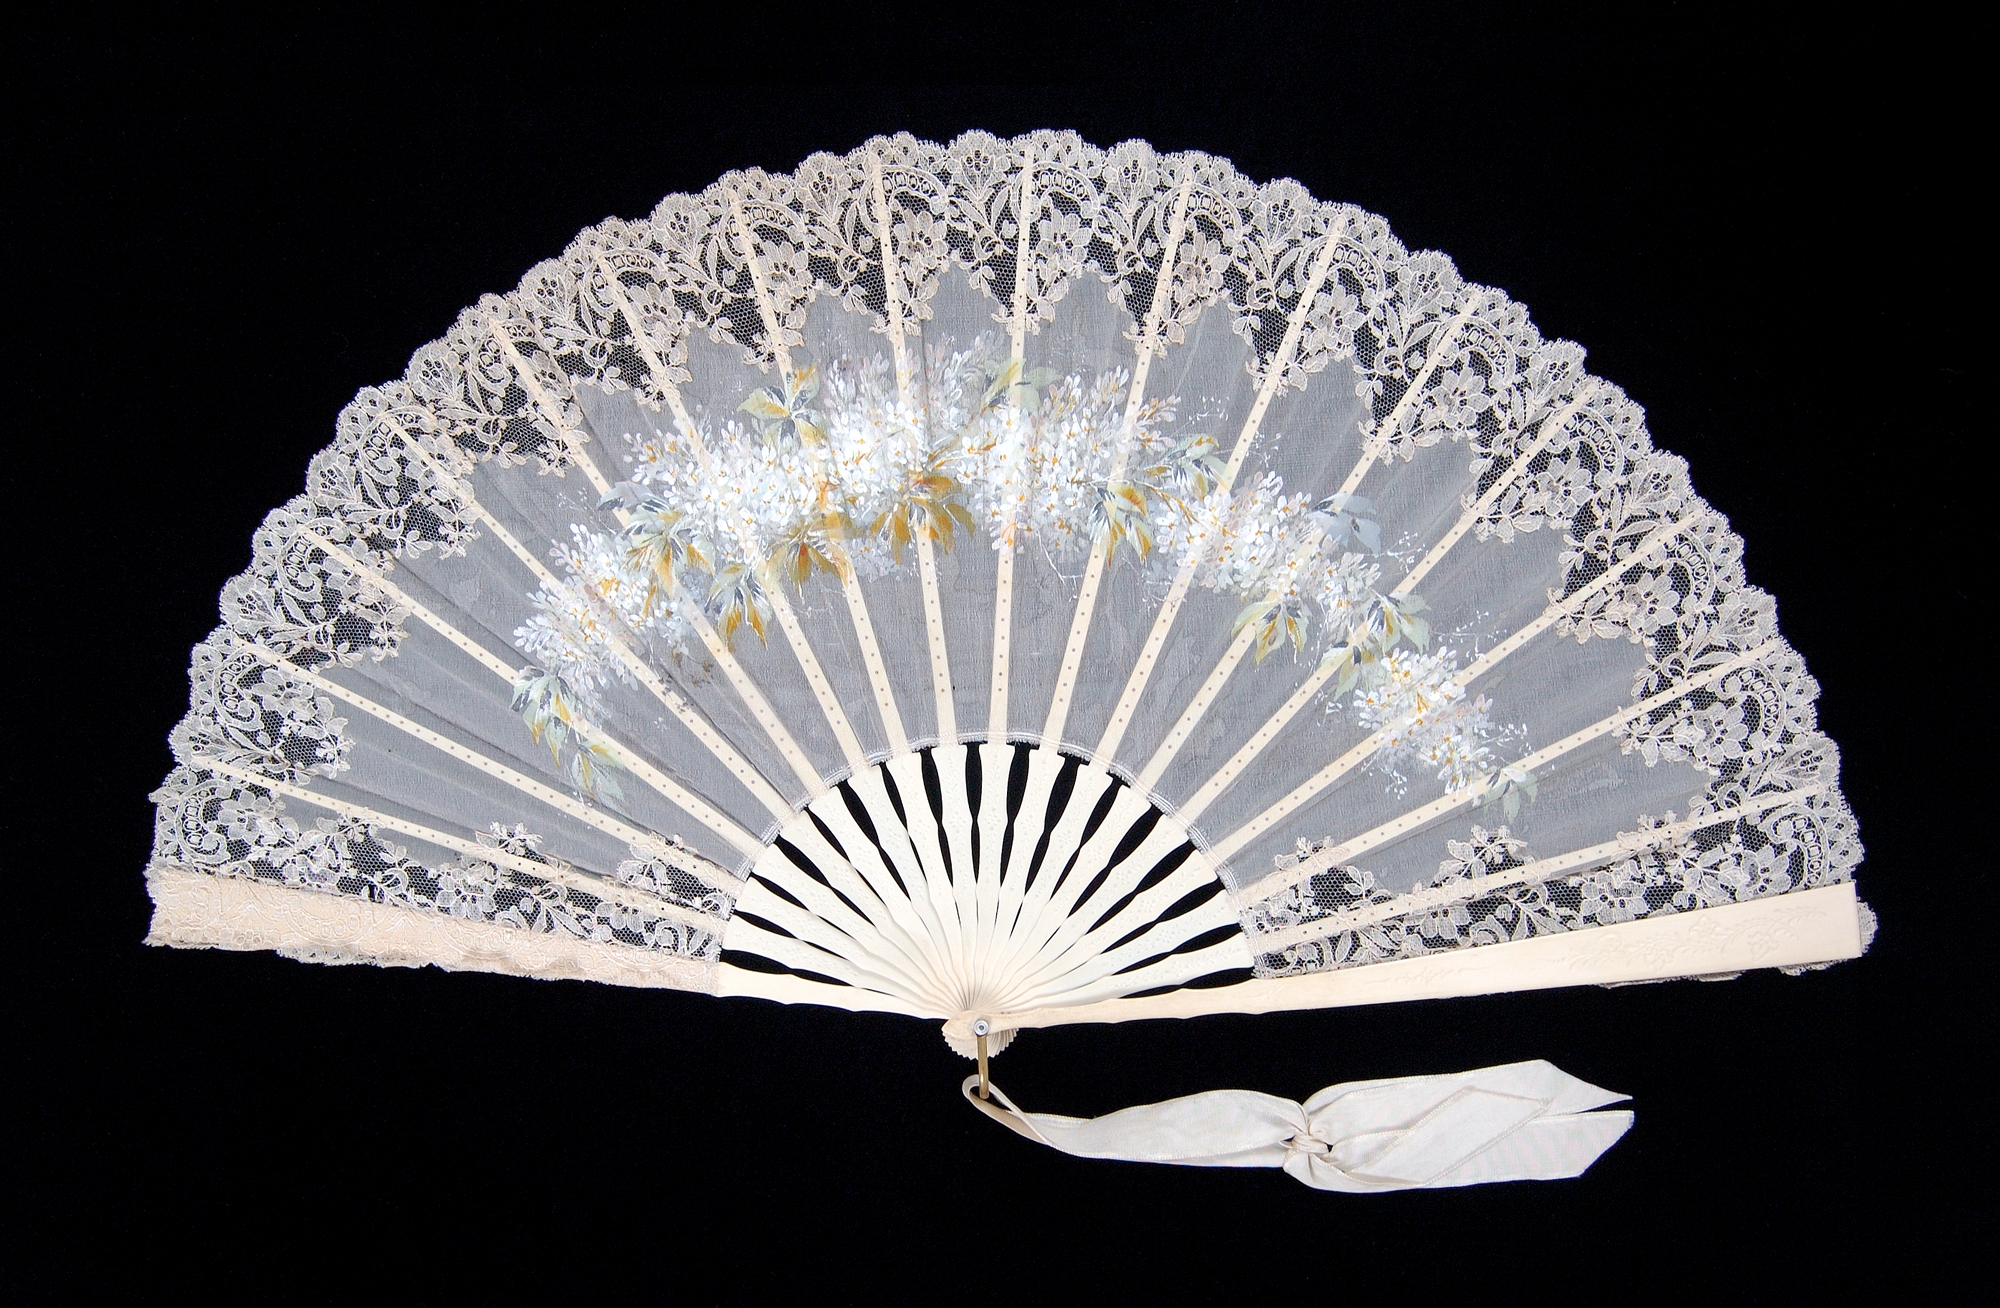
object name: fan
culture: french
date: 1885-1895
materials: ivory, metal, mother of pearl, silk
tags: flowers